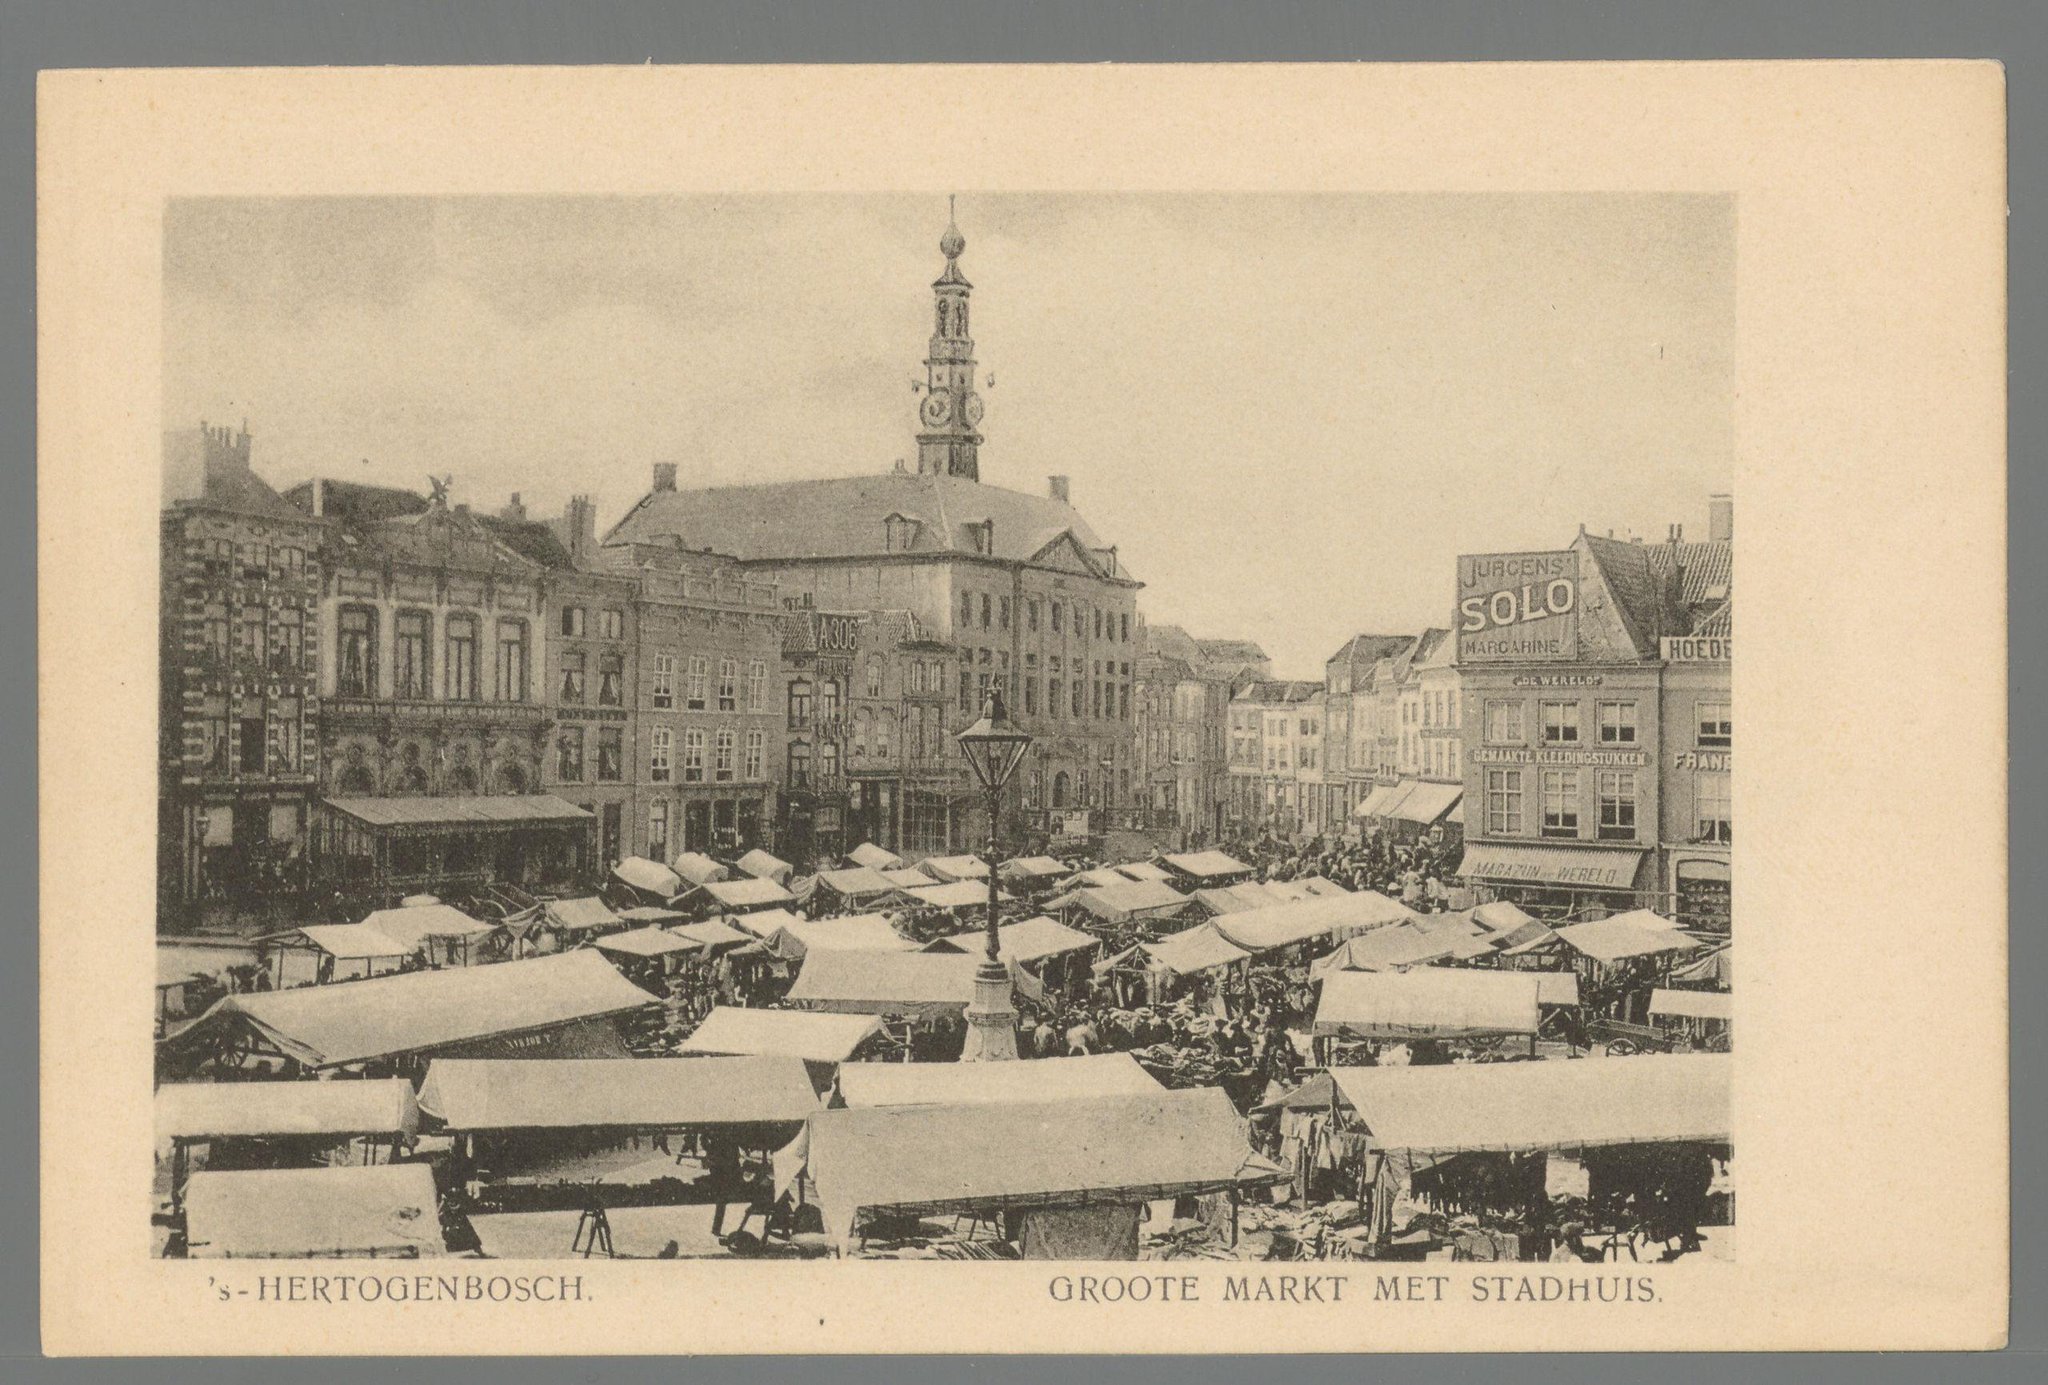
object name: ansichtkaart, prentbriefkaart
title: 's-Hertogenbosch. Groote markt met stadhuis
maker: Anonymous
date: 1905-1930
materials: cardboard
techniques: photograph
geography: den bosch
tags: city-view, and landscape with man-made constructions, townhall, market